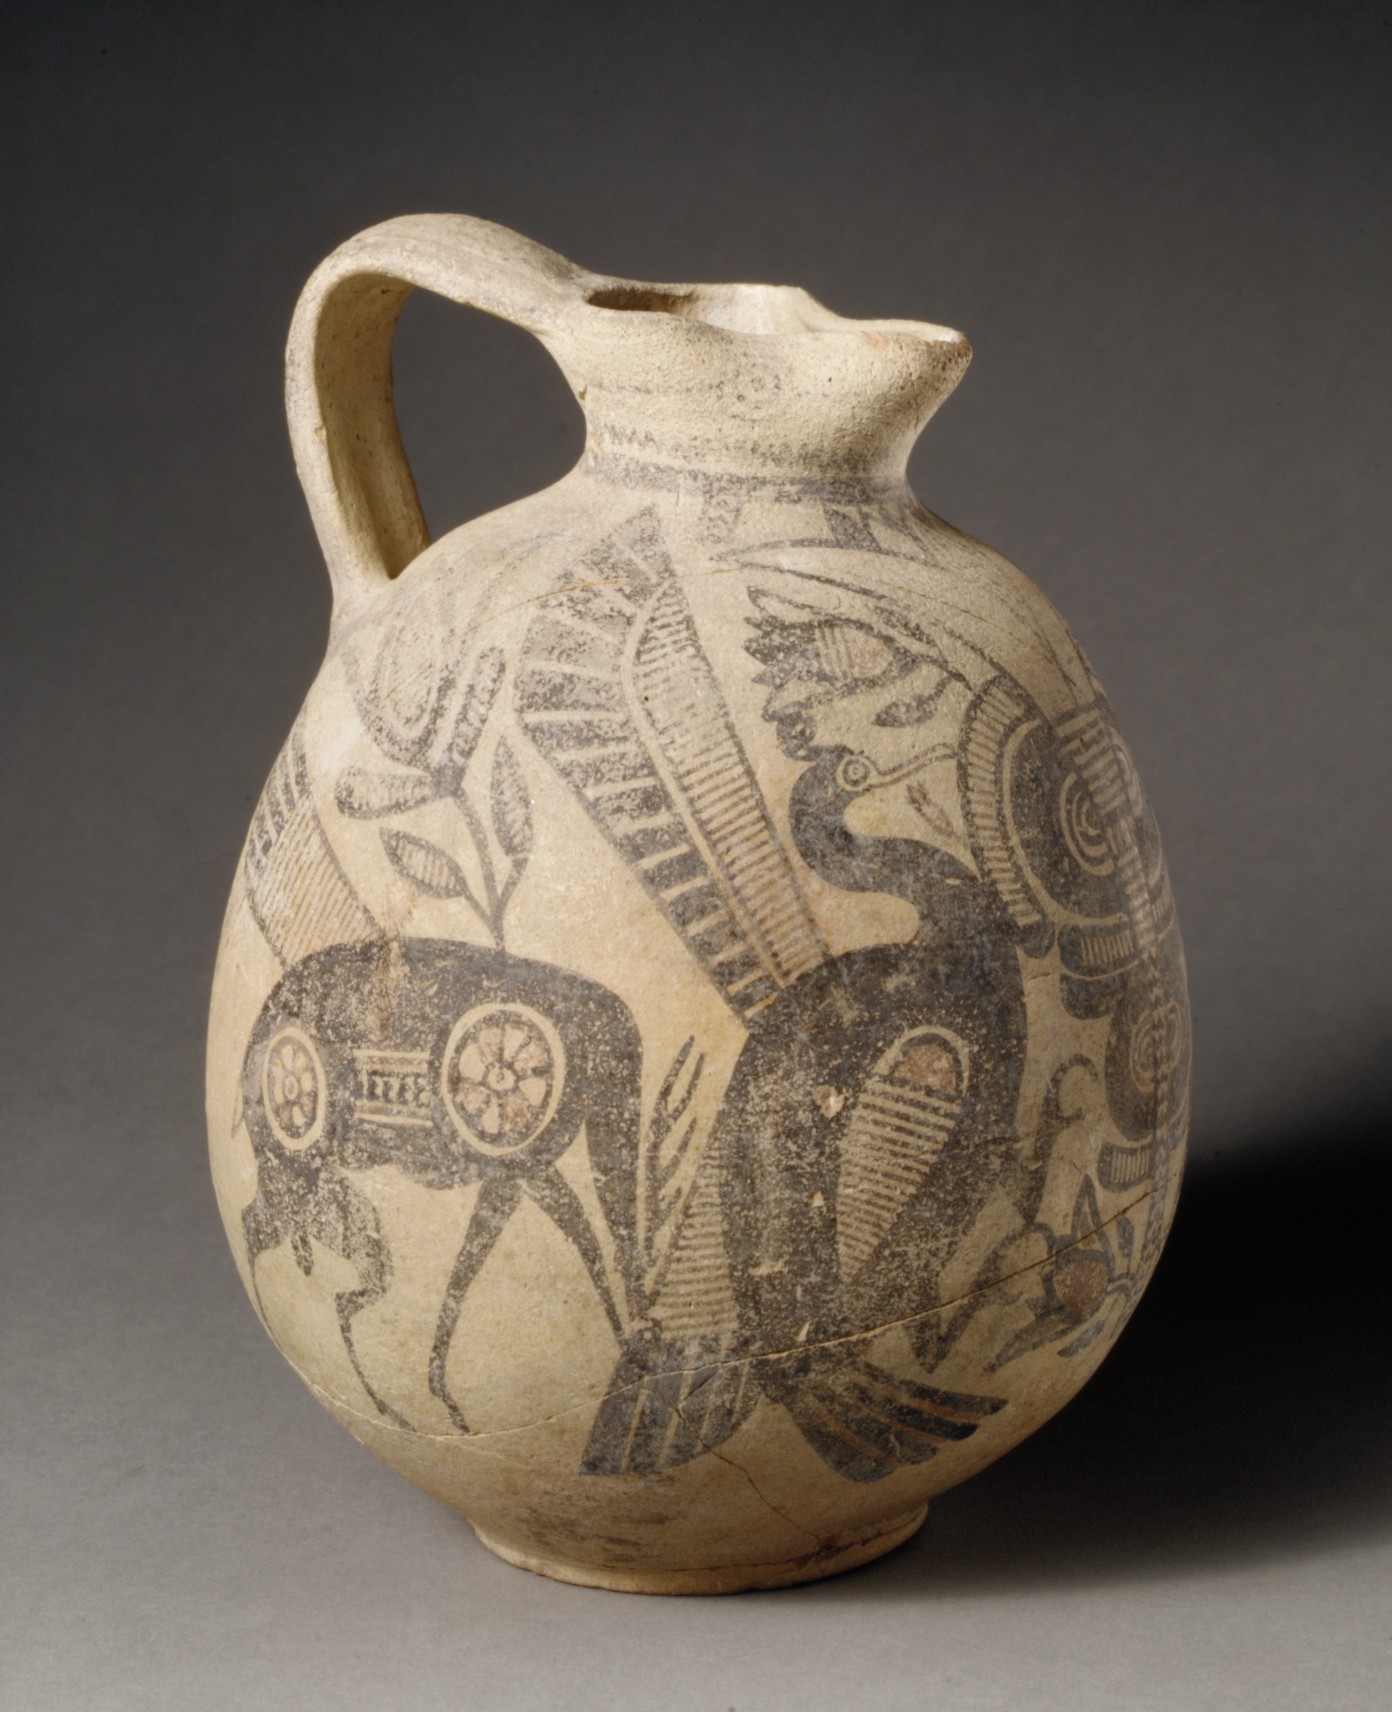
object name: jug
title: Terracotta jug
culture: cypriot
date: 750-600 BCE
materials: terracotta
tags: animals,birds